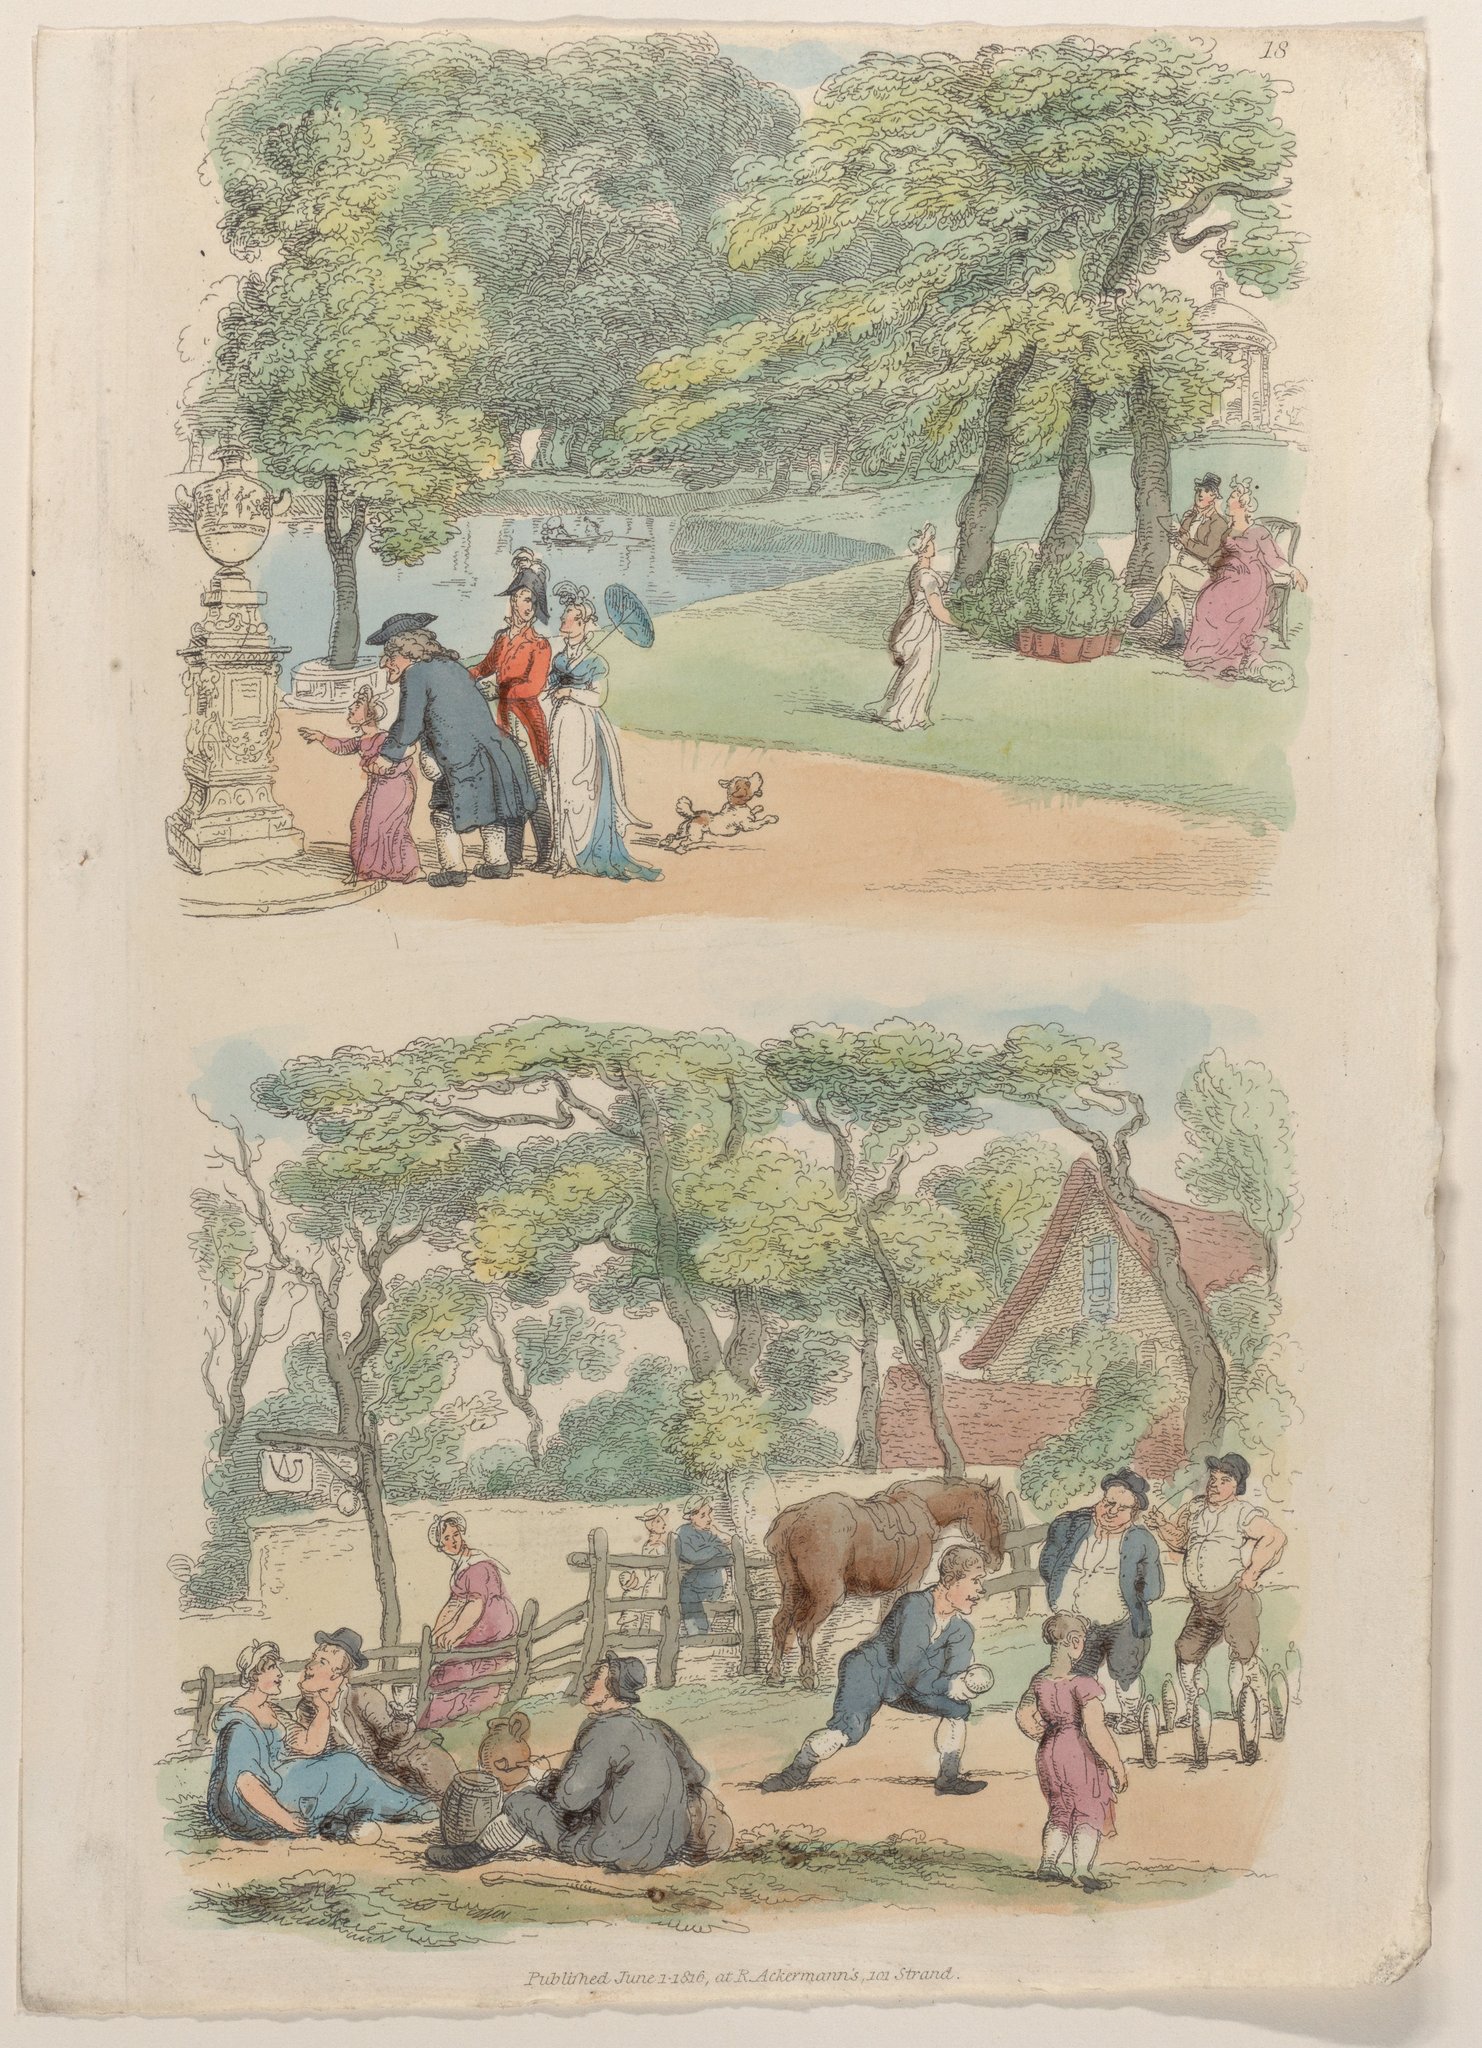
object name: print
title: Plate 18, from "World in Miniature"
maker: thomas rowlandson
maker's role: artist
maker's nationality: british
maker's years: 1757-1827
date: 1816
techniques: etching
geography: london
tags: men,women,dogs,horses,games